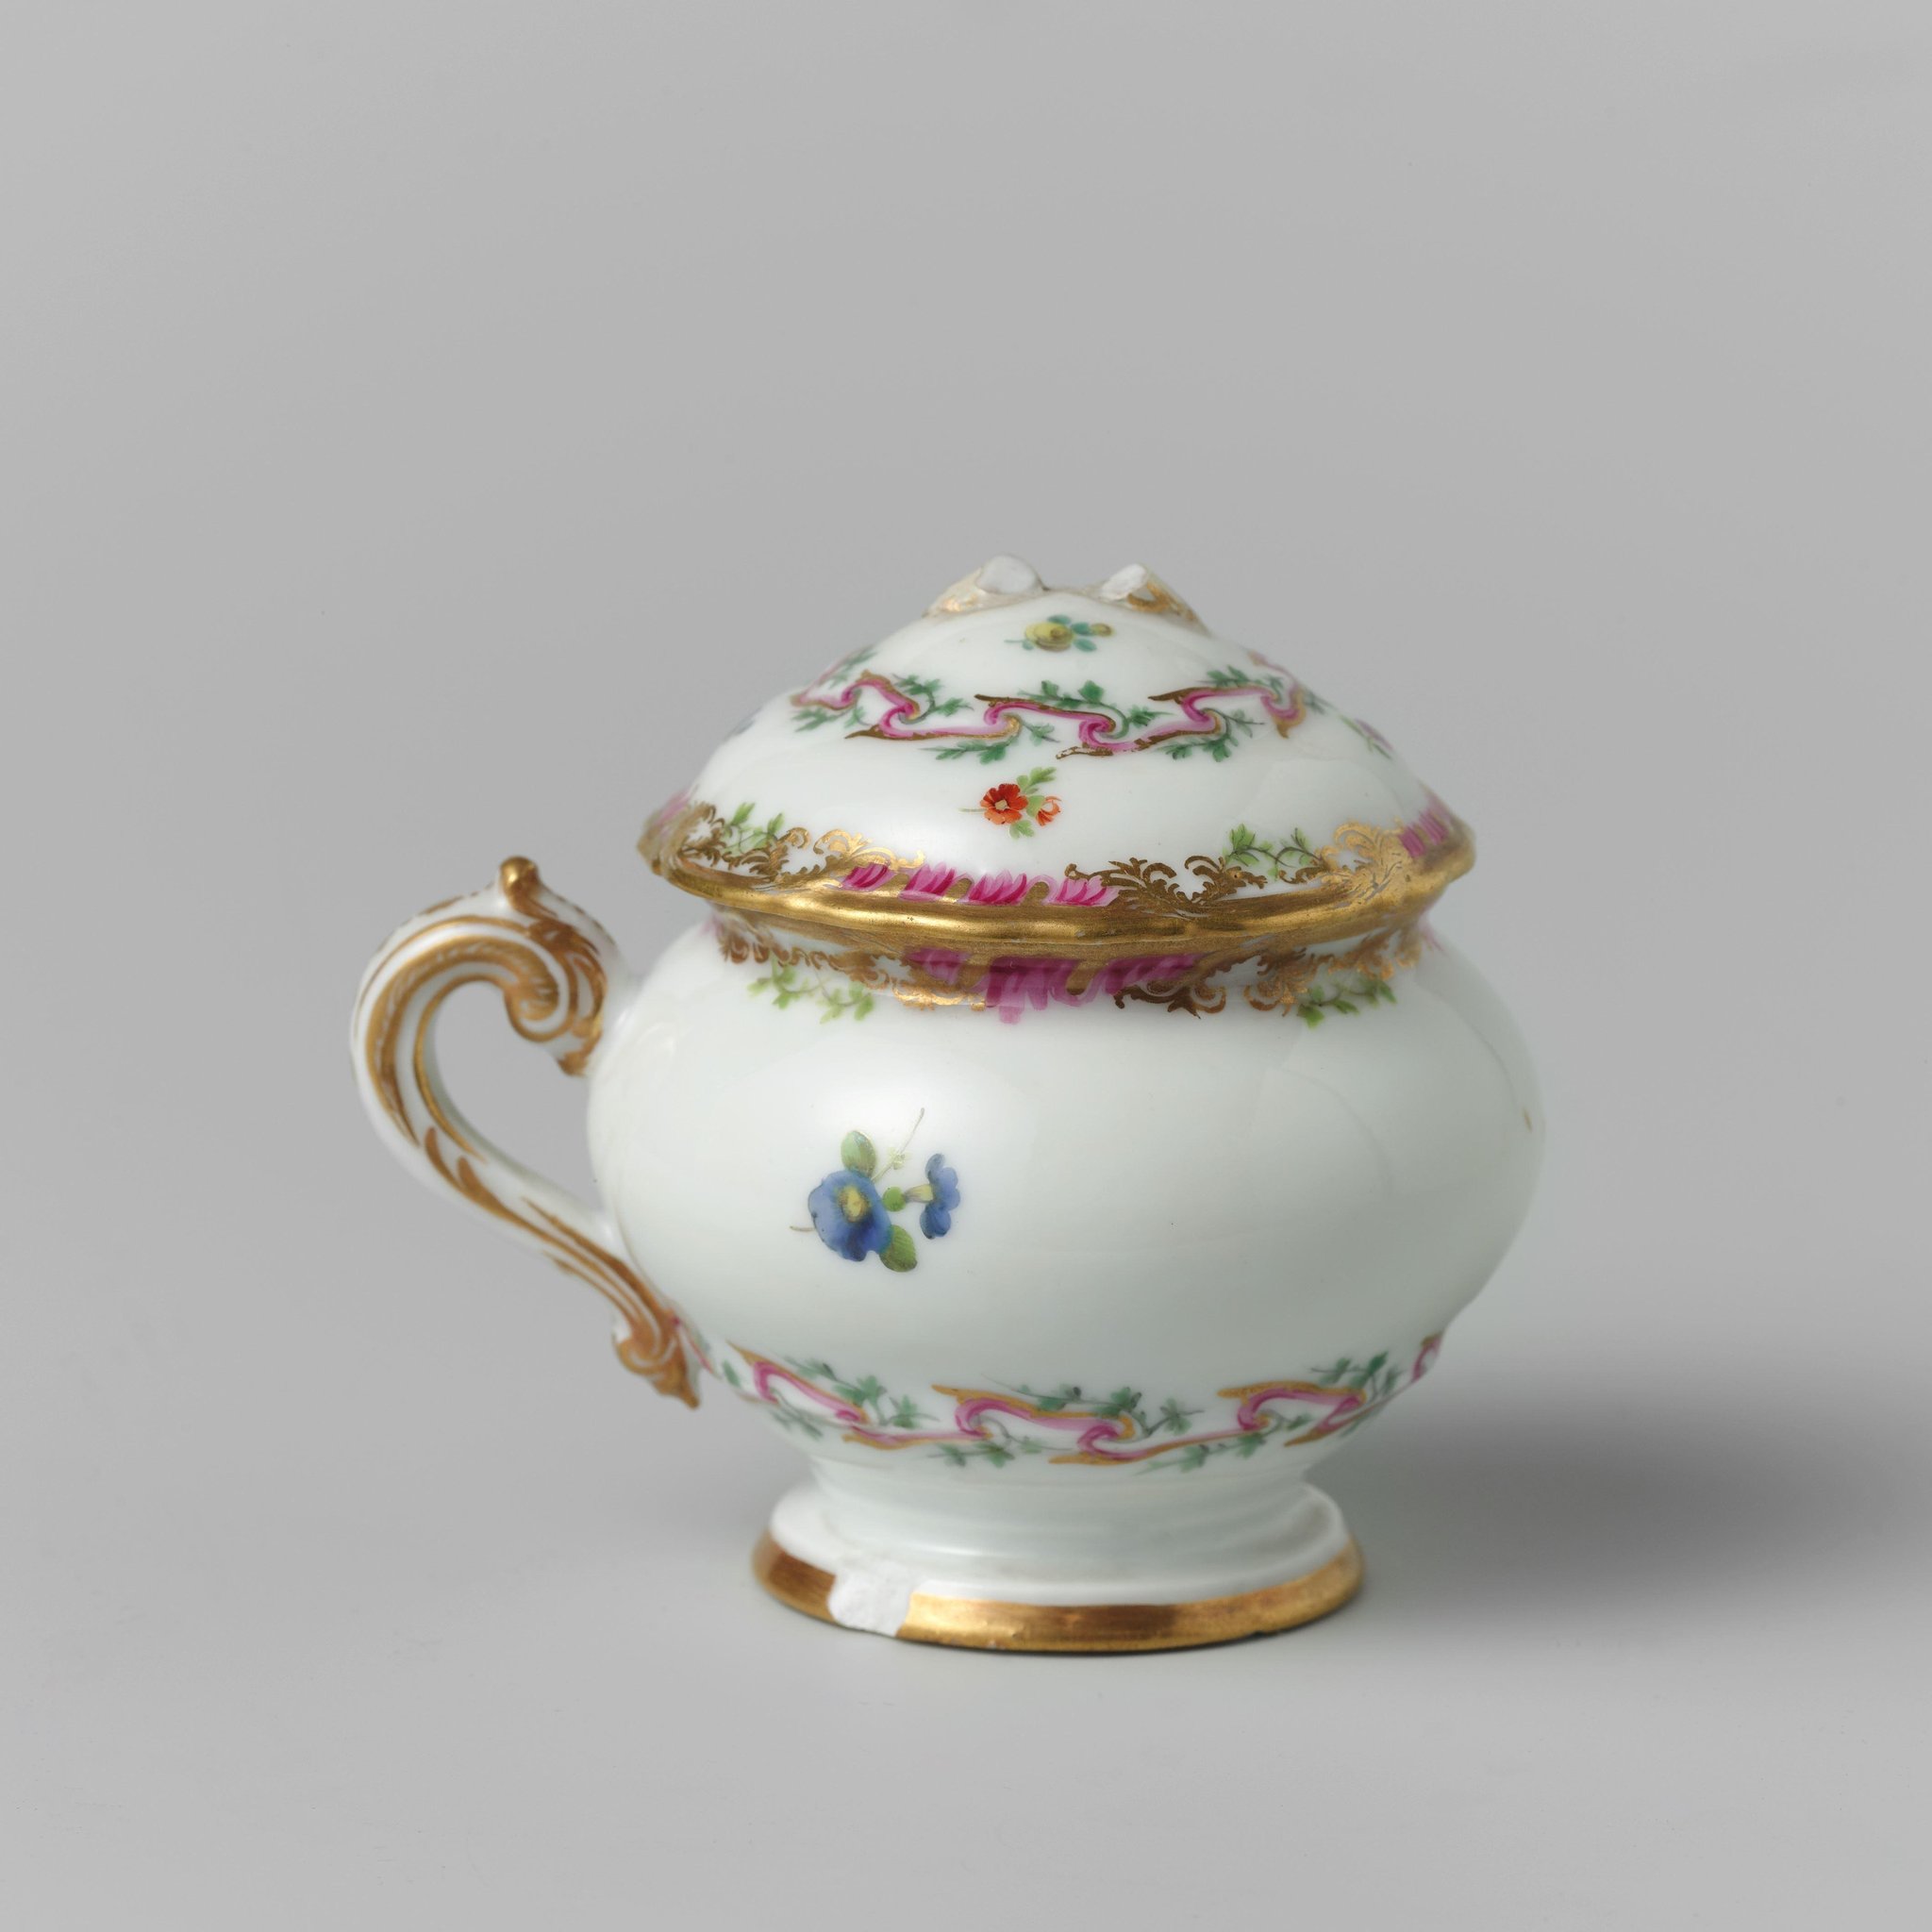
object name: pot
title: Deksel van pasteipot, behorend bij een servies met geslingerd lintmotief met bladertakken, bloemboeketten en gestrooide bloemtakken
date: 1780-1820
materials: porcelain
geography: loosdrecht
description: Deksel van pasteipot, behorend bij een servies van porselein met geslingerd motief in paars en goud met groene bladertakken, bloemboeketten en gestrooide bloemtakken. Randen lichtgegolfd met decoratie in goud met paars bladmotief waartussen groen gekruist bladmotief.